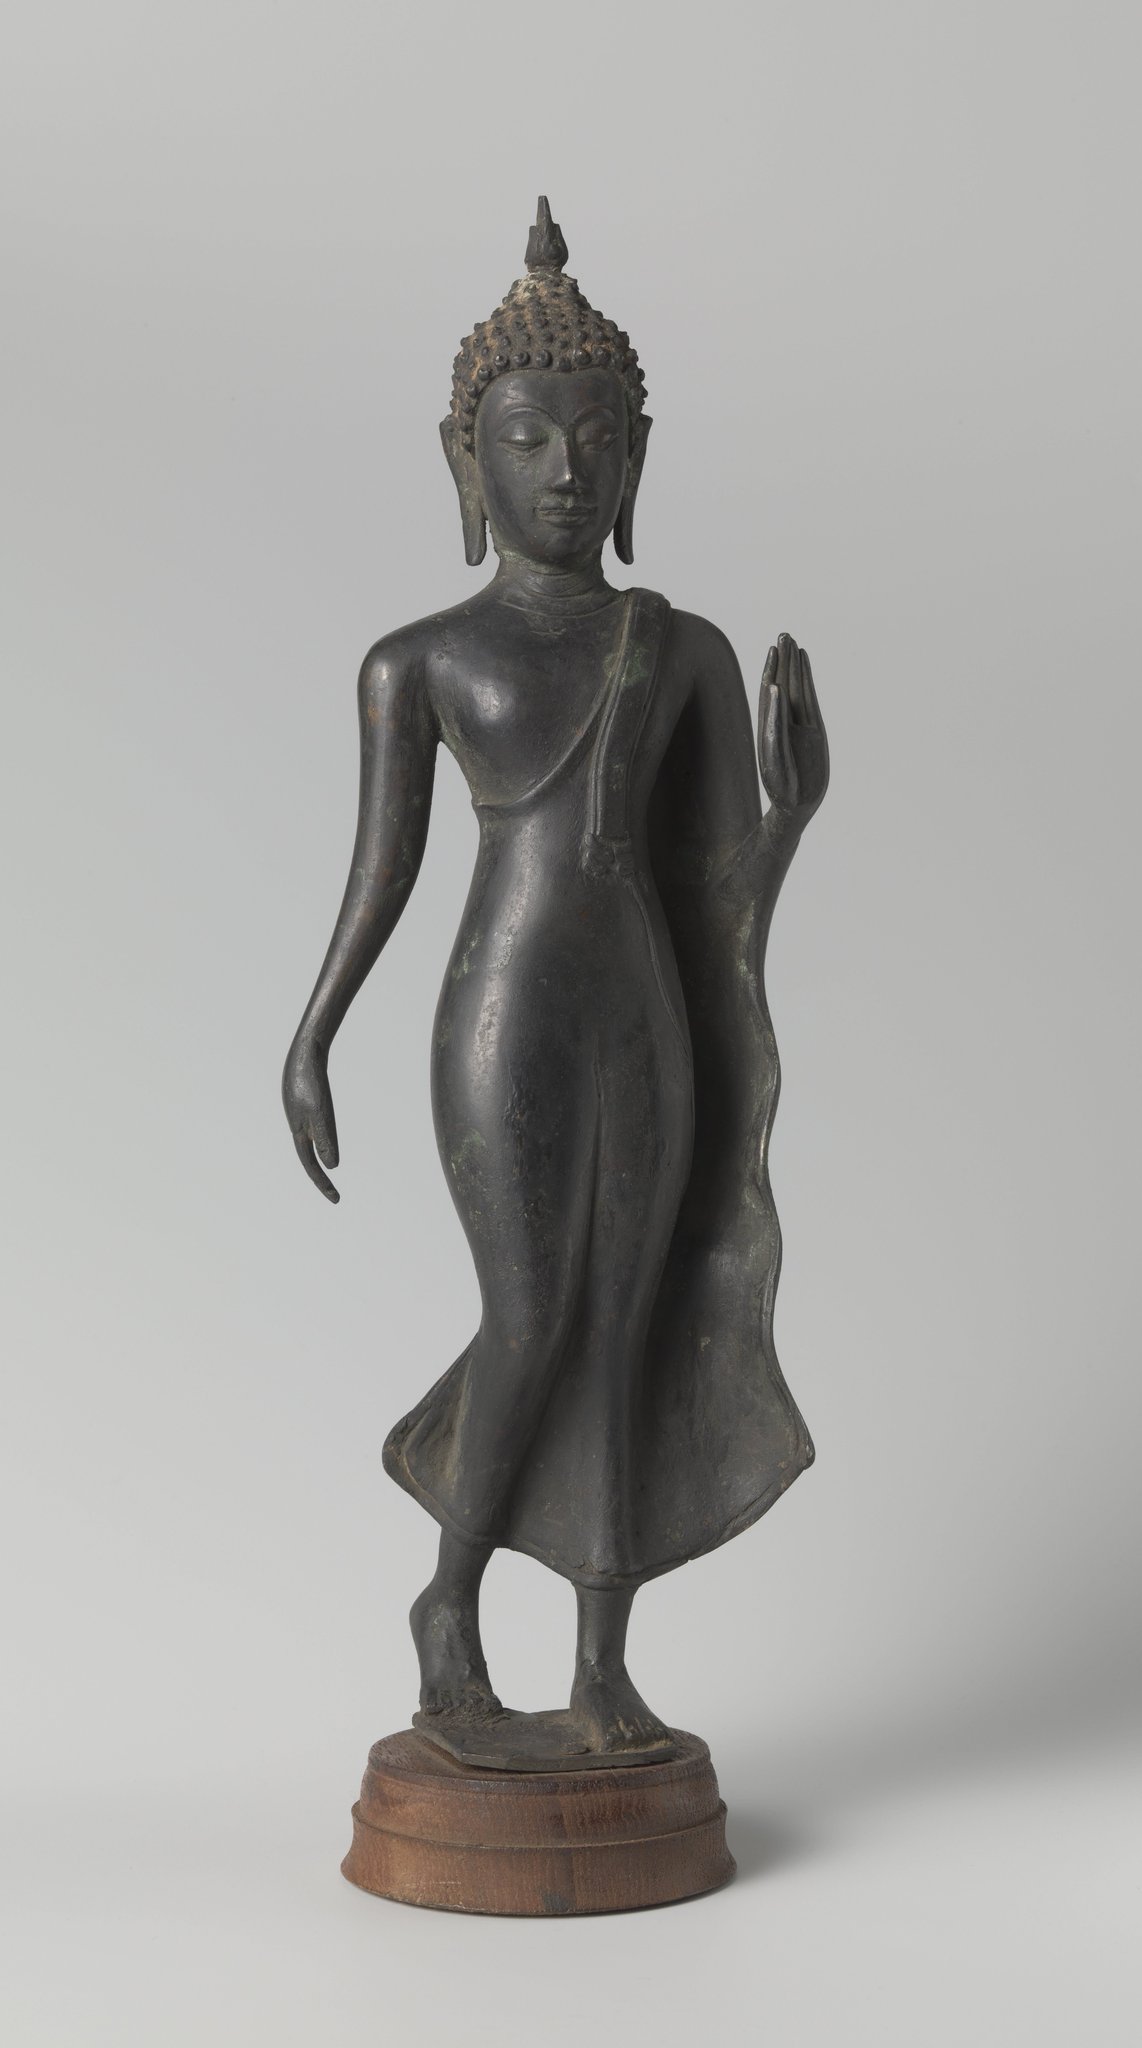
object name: boeddha kop, boeddha beeld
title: Lopende Boeddha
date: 1750-1900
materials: bronze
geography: thailand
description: Lopende Boeddha, Sukhodaya-type; vals. Op sokkel.